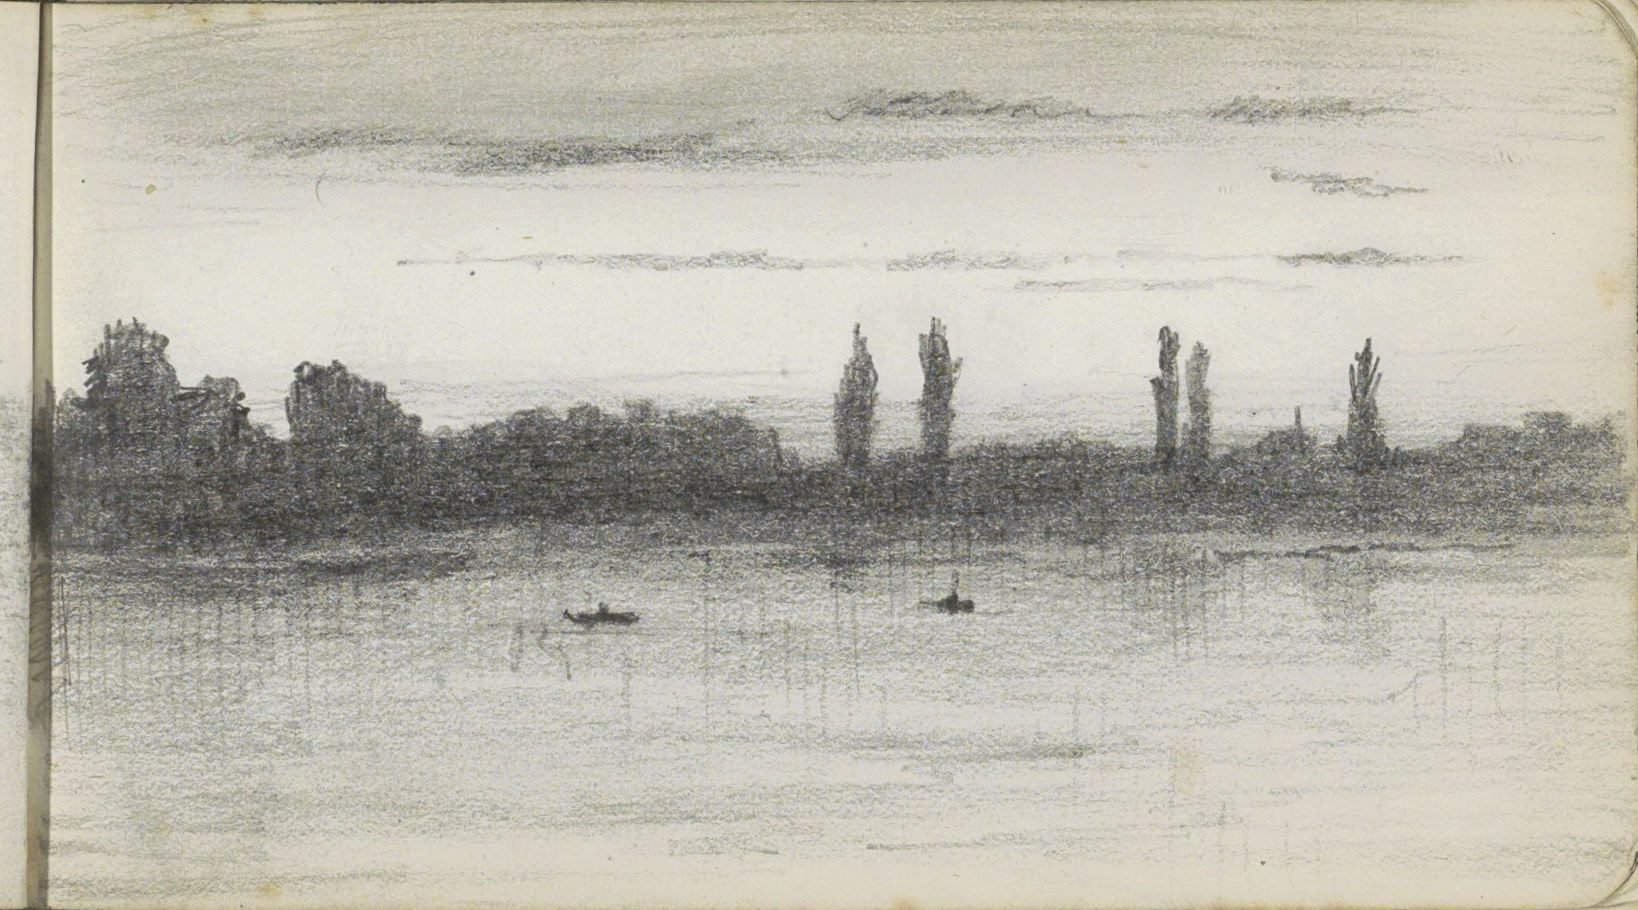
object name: sketchbook leaf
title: Gezicht op Bazel aan de Rijn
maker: geo poggenbeek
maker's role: draughtsman, painter, print maker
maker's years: 1853-1903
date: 1807-1876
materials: paper, pencil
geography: basel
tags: city-view, and landscape with man-made constructions, river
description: Blad 51 recto uit een schetsboek met 69 bladen.